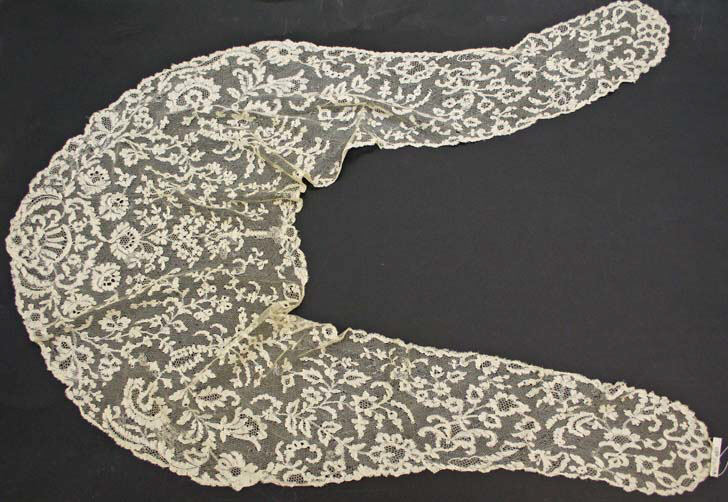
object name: collar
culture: british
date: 1826-1850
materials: linen